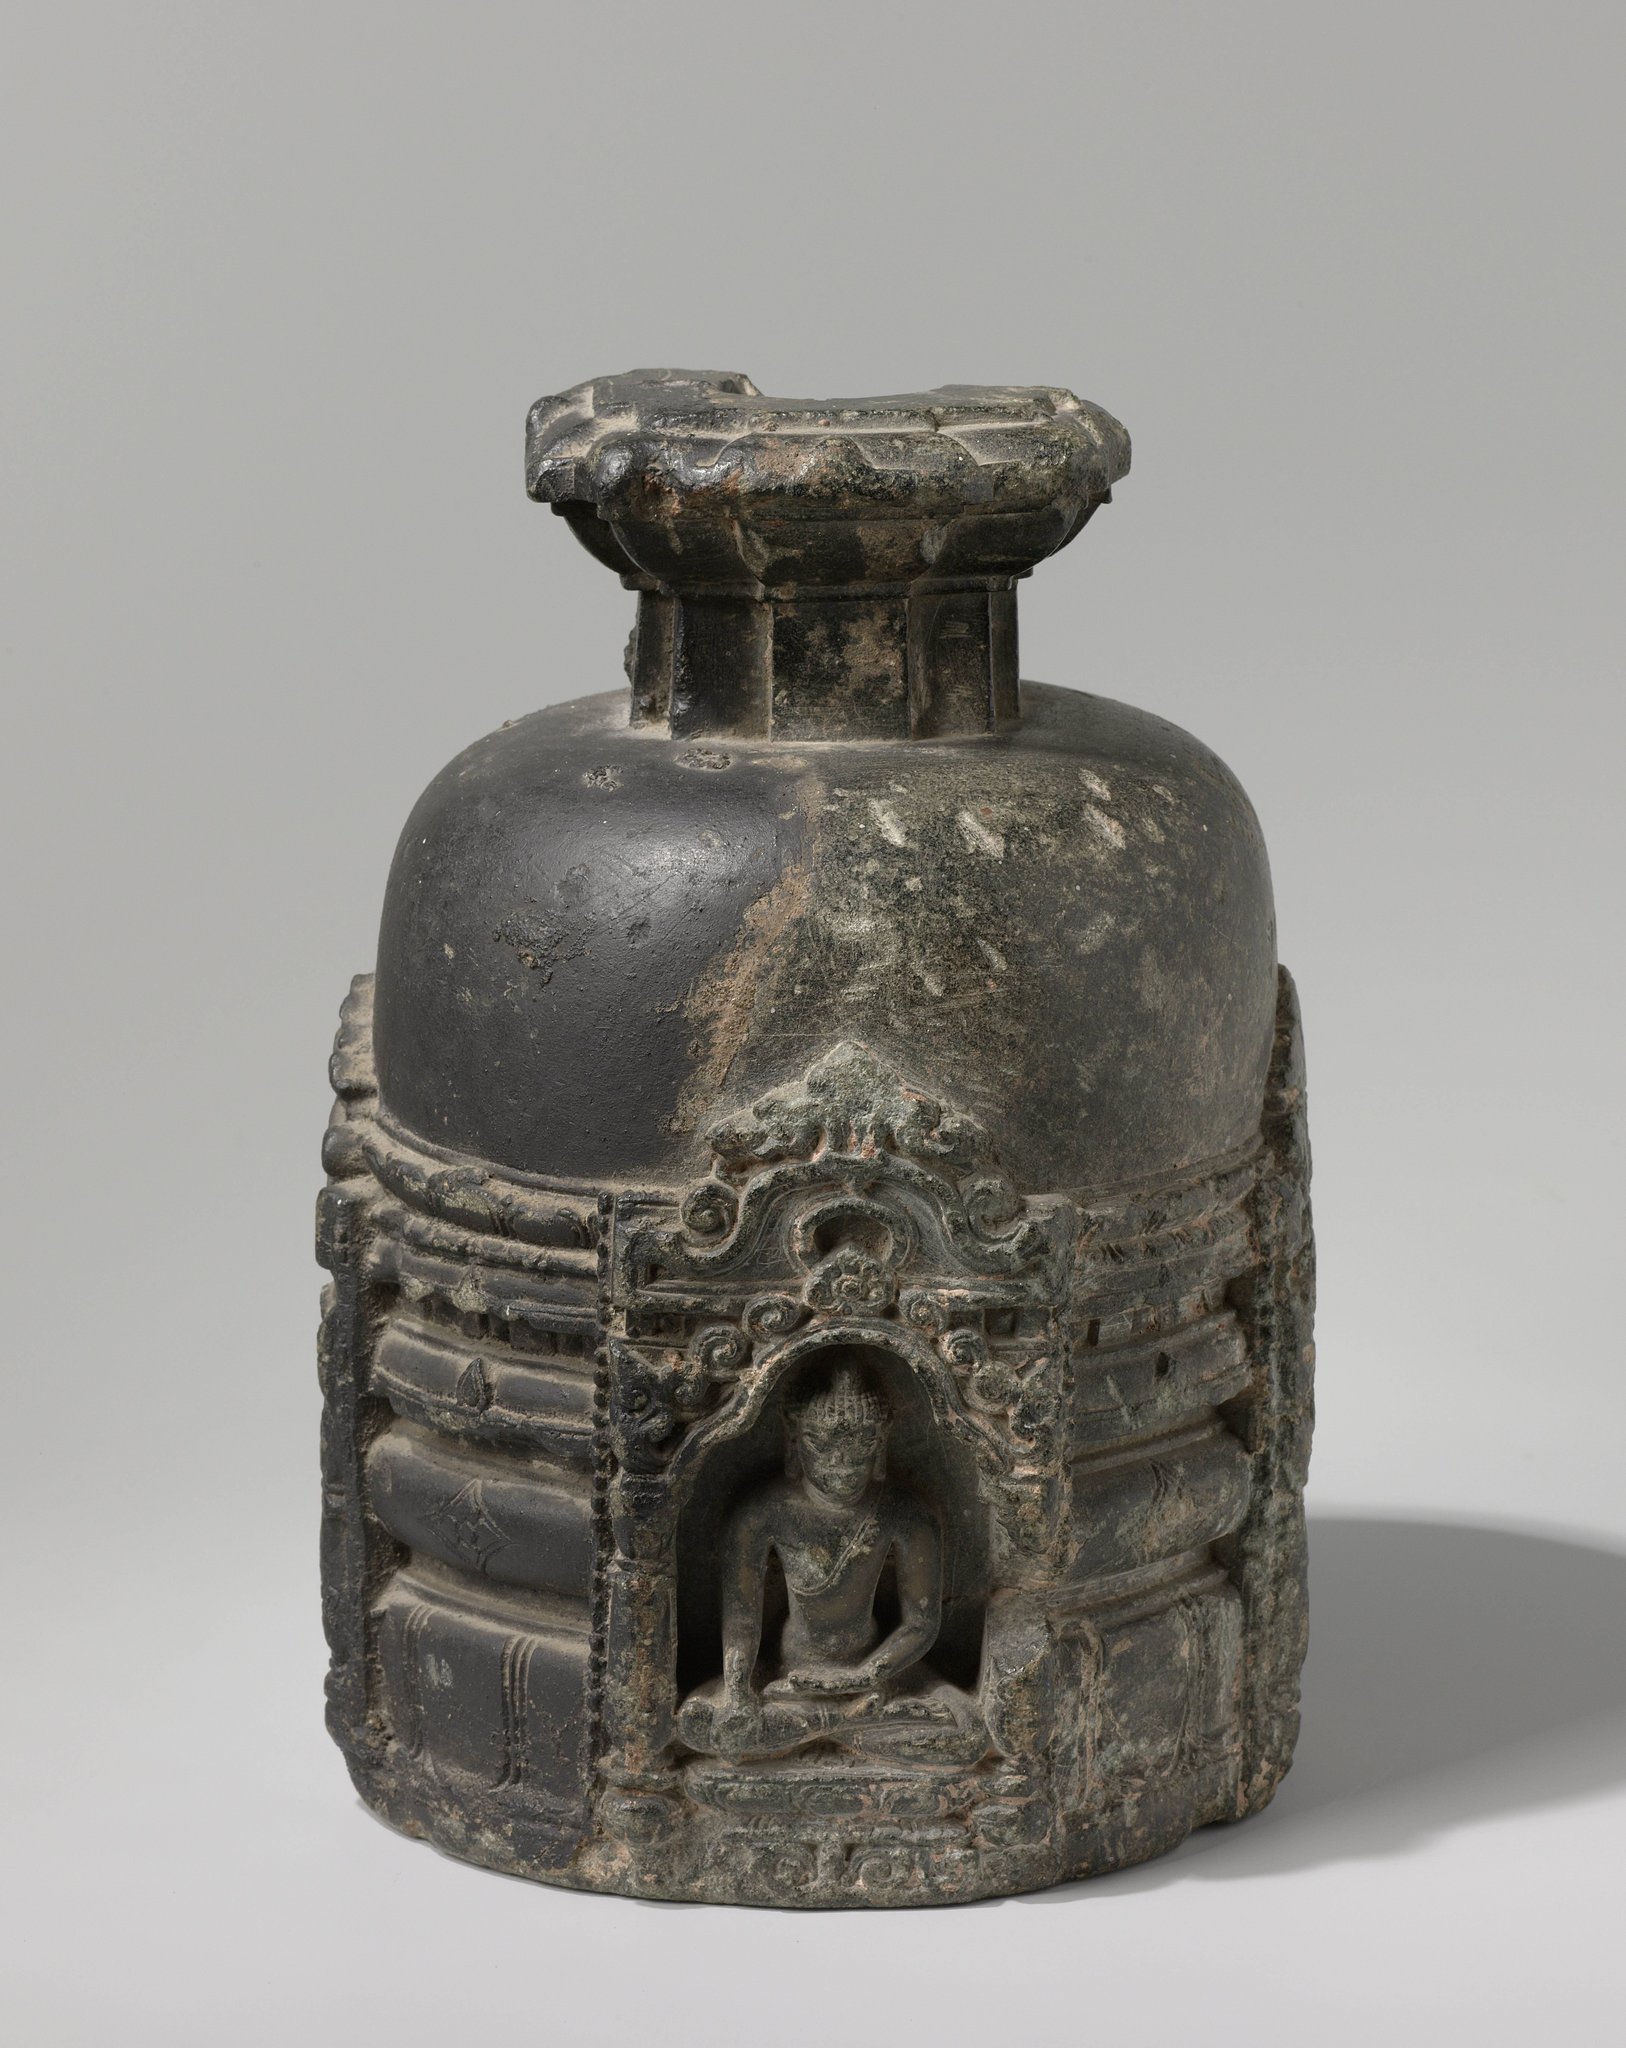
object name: sculpture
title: Votive Stupa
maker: Anonymous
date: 900-1100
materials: limestone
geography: bihar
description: A stupa is a hemispherical Buddhist structure built to commemorate the Buddha. Miniature stupas were commissioned by Buddhist pilgrims and offered to monasteries. Human ashes and bones have been found in some of these small stupas; it was considered highly auspicious to be buried in a place visited by the Buddha or where his relics were kept.